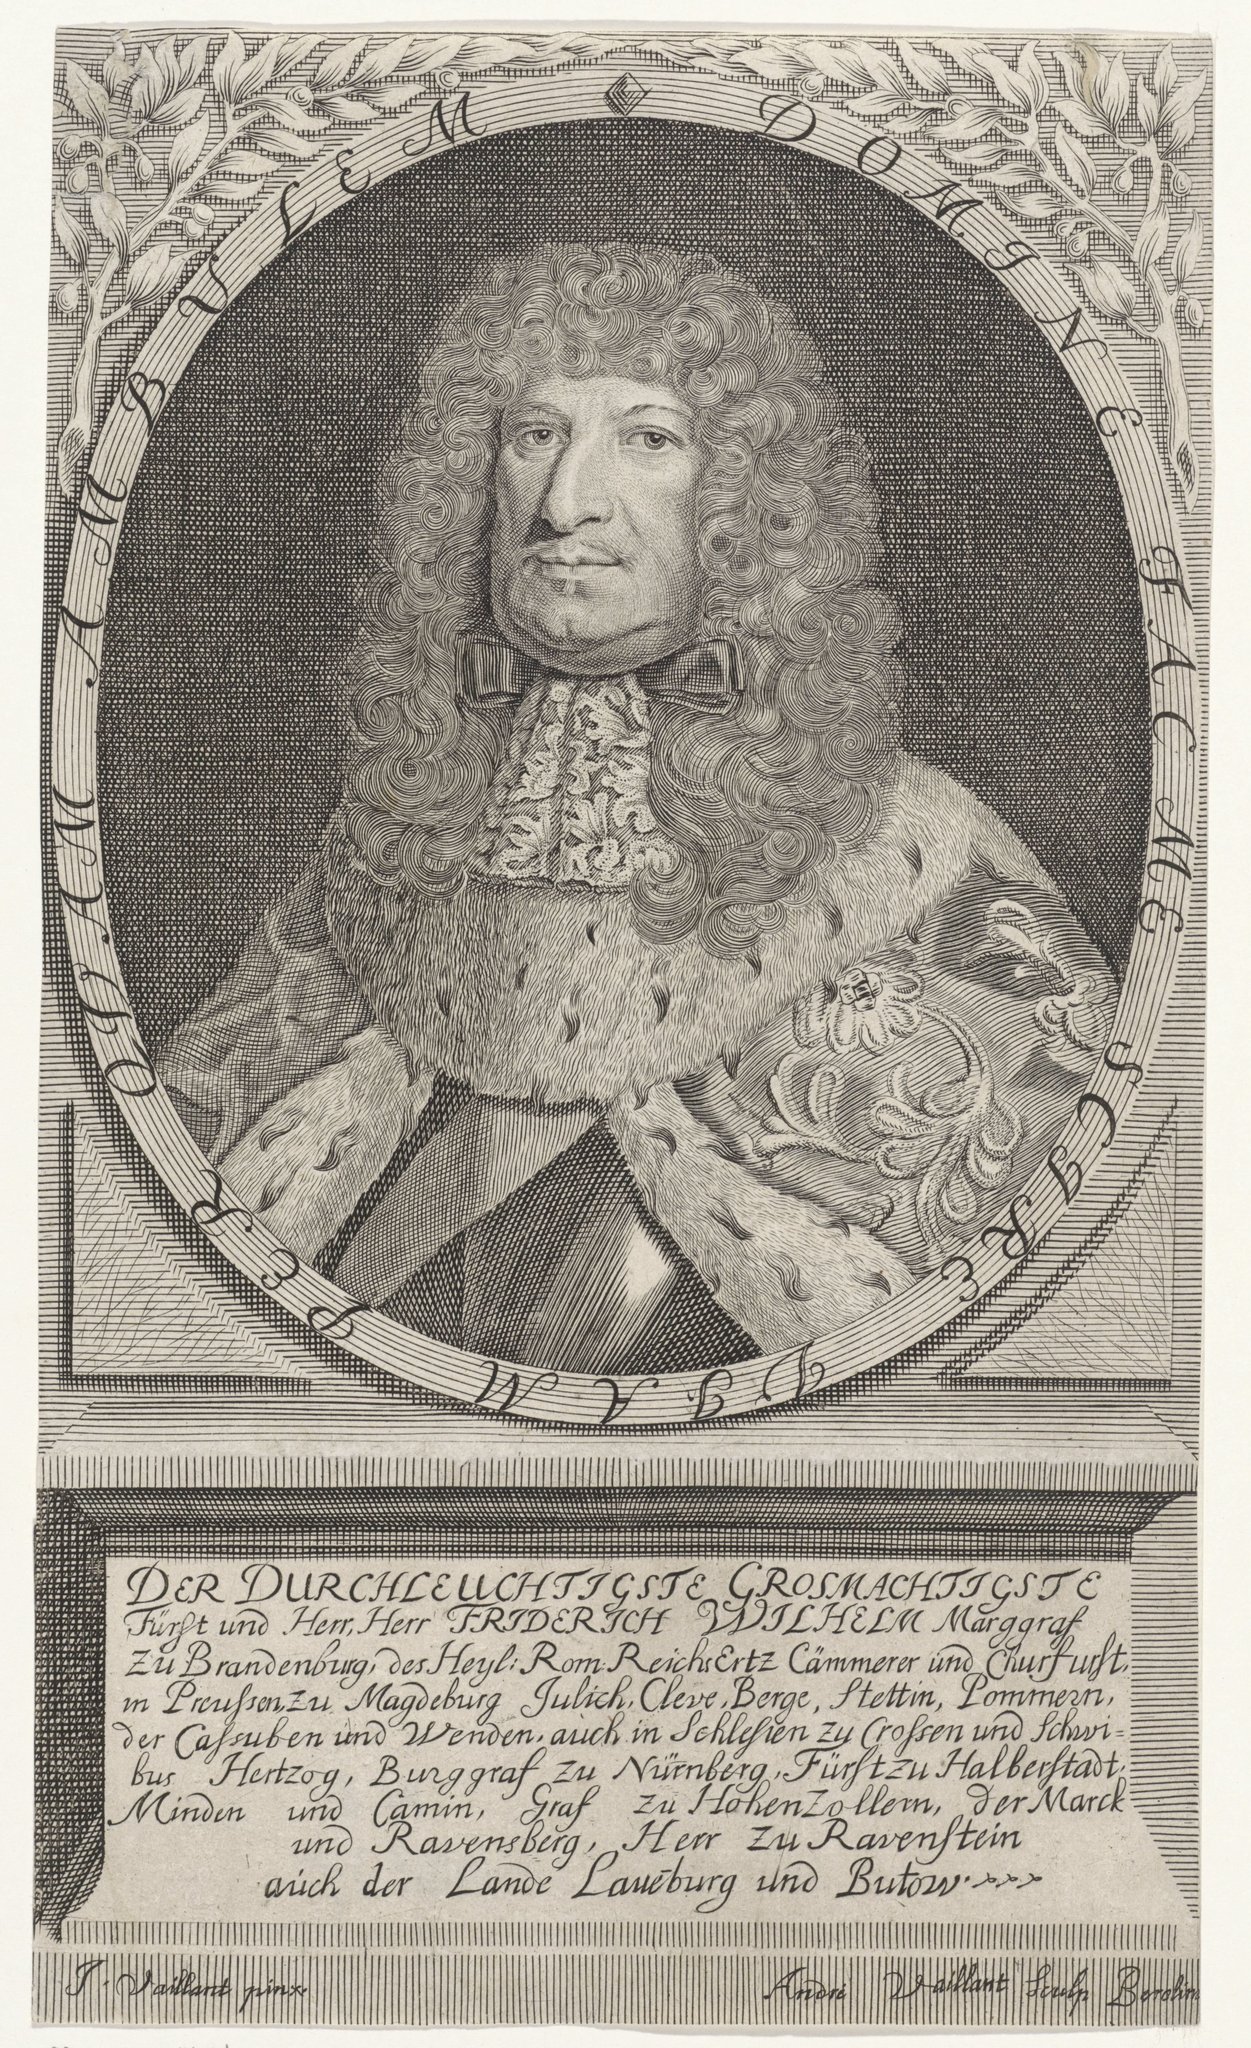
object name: print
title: Portret van Frederik Willem, keurvorst van Brandenburg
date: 1685-1693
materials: paper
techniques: engraving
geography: berlin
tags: berlin, frederik willem van brandenburg (i)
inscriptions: collector's mark: Lugt 2228